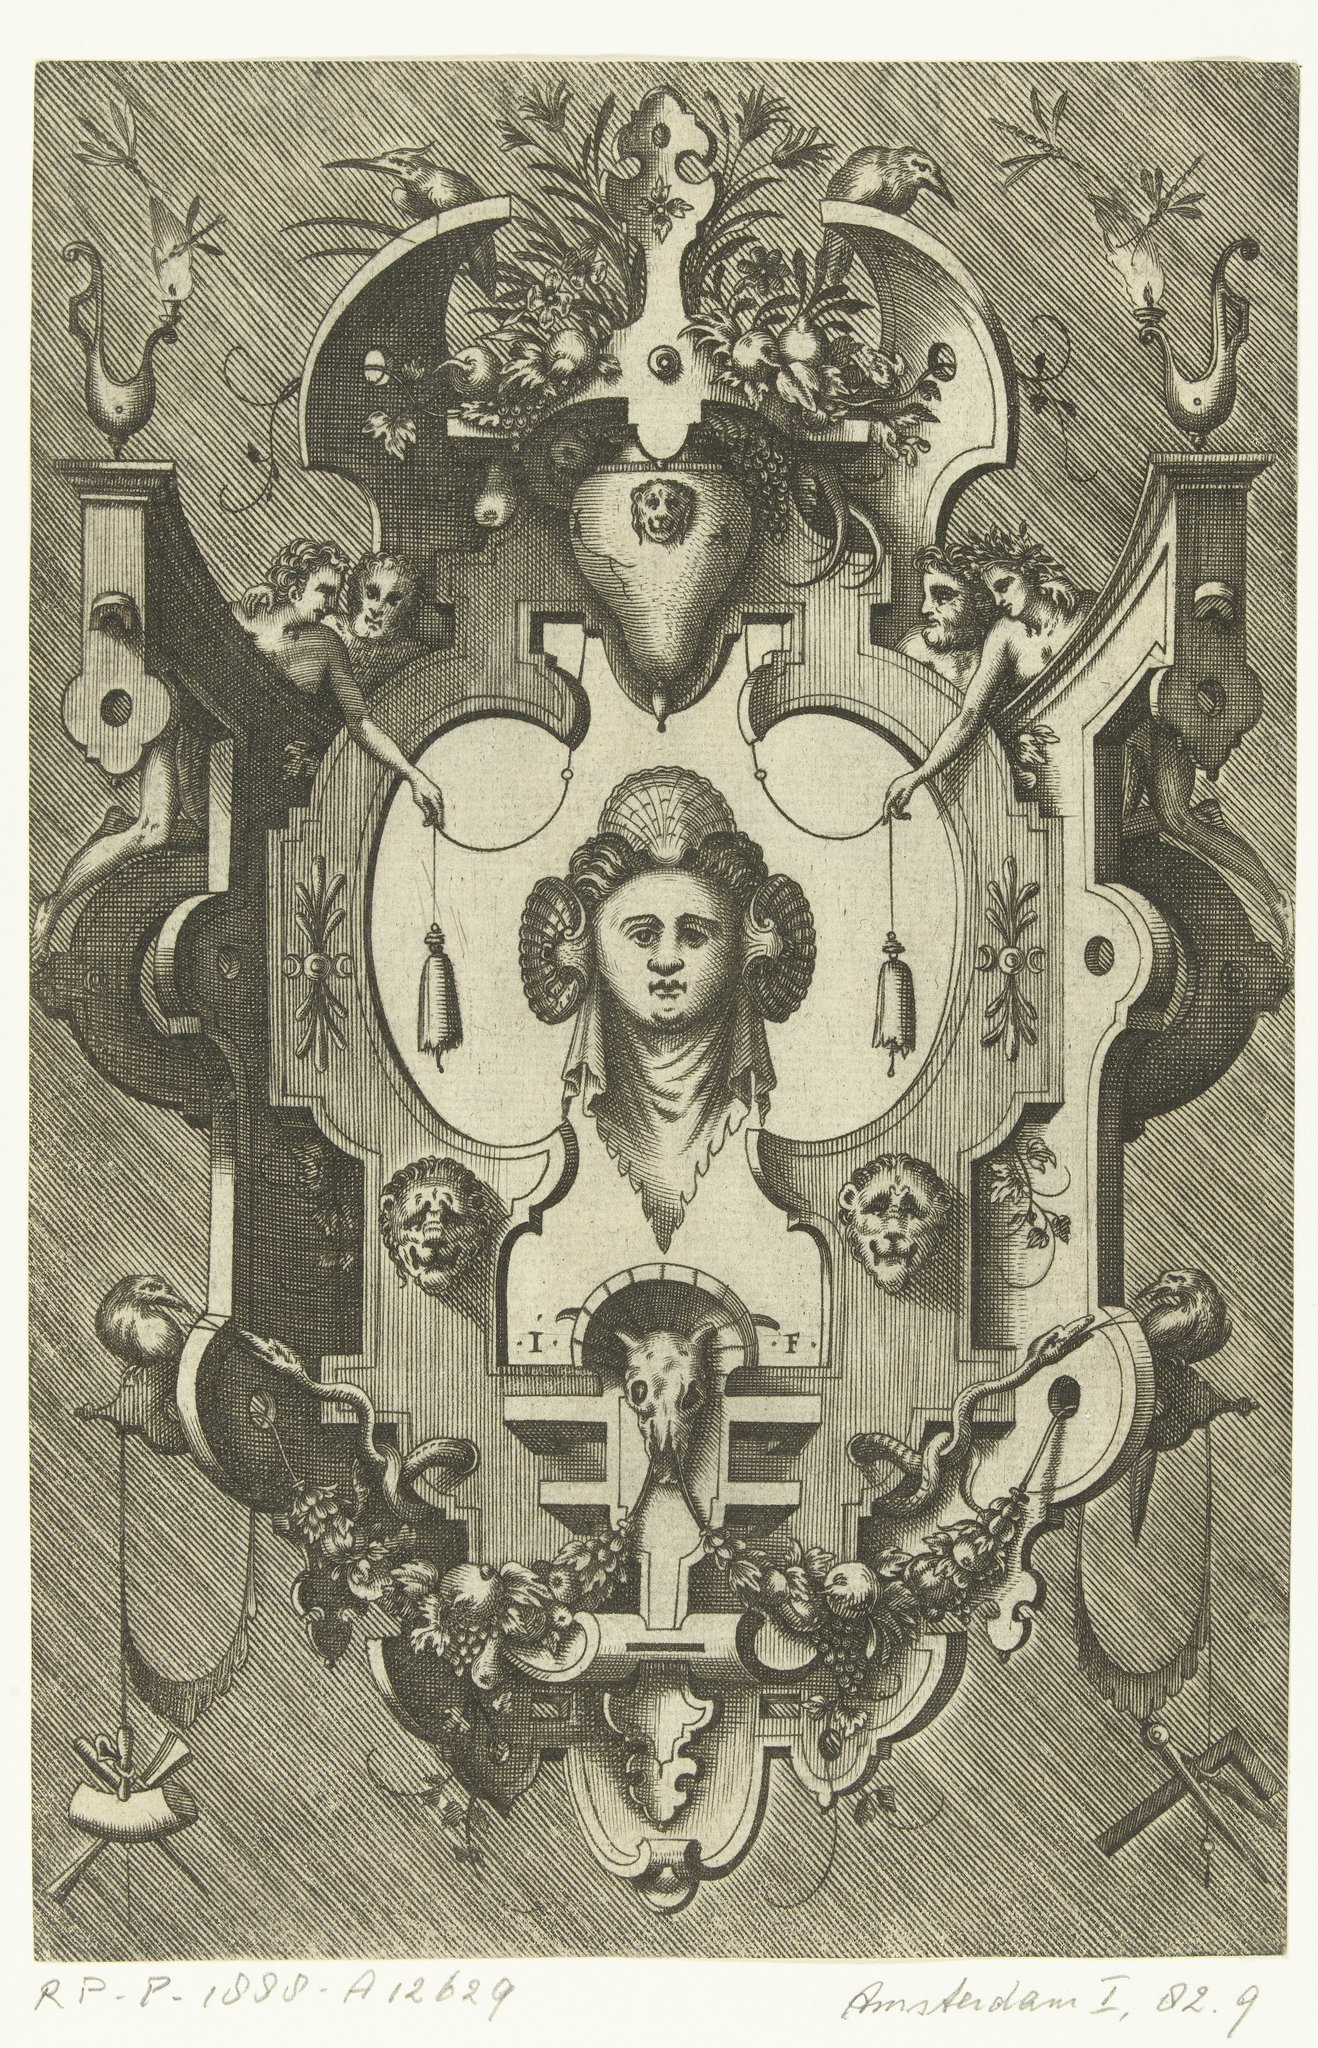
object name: ornament print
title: Compertimenta pictoriis flosculis manubiisque…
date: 1567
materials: paper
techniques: engraving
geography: netherlands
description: De cartouche wordt bekroond door een vaas met bloemen en fruit. Zowel links als rechts hangen over het rolwerk een man en een vrouw. Gearceerde achtergrond. Hoort bij serie van 14 bladen cartouches met rolwerk, grotesken, trofeeën en friezen. Het titelblad ontbreekt.